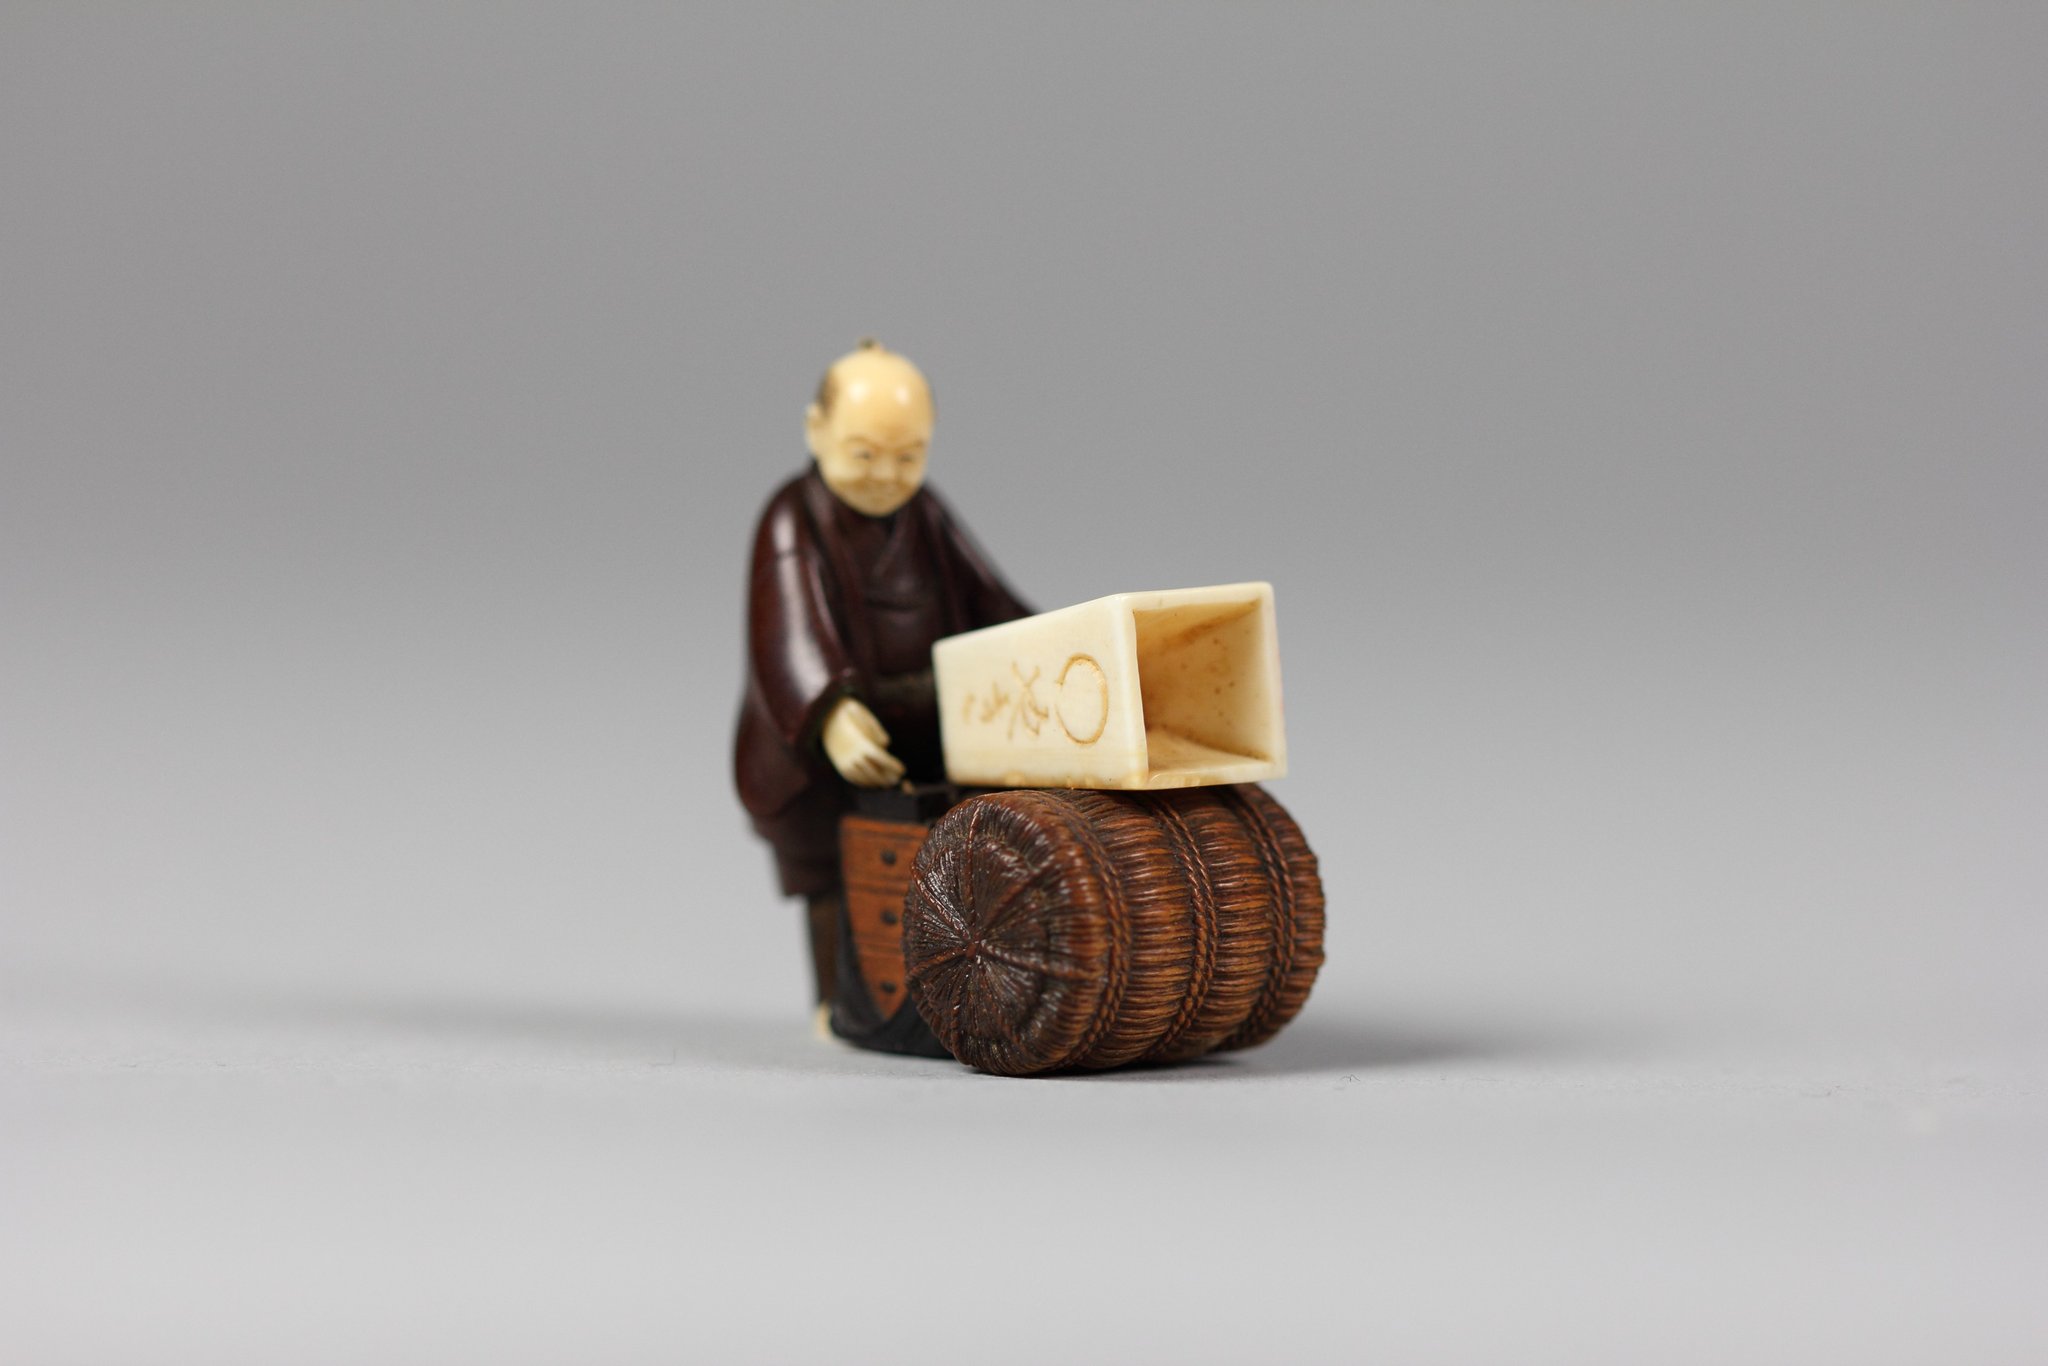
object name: netsuke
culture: japanese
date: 1801-1900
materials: ivory, wood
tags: men,baskets